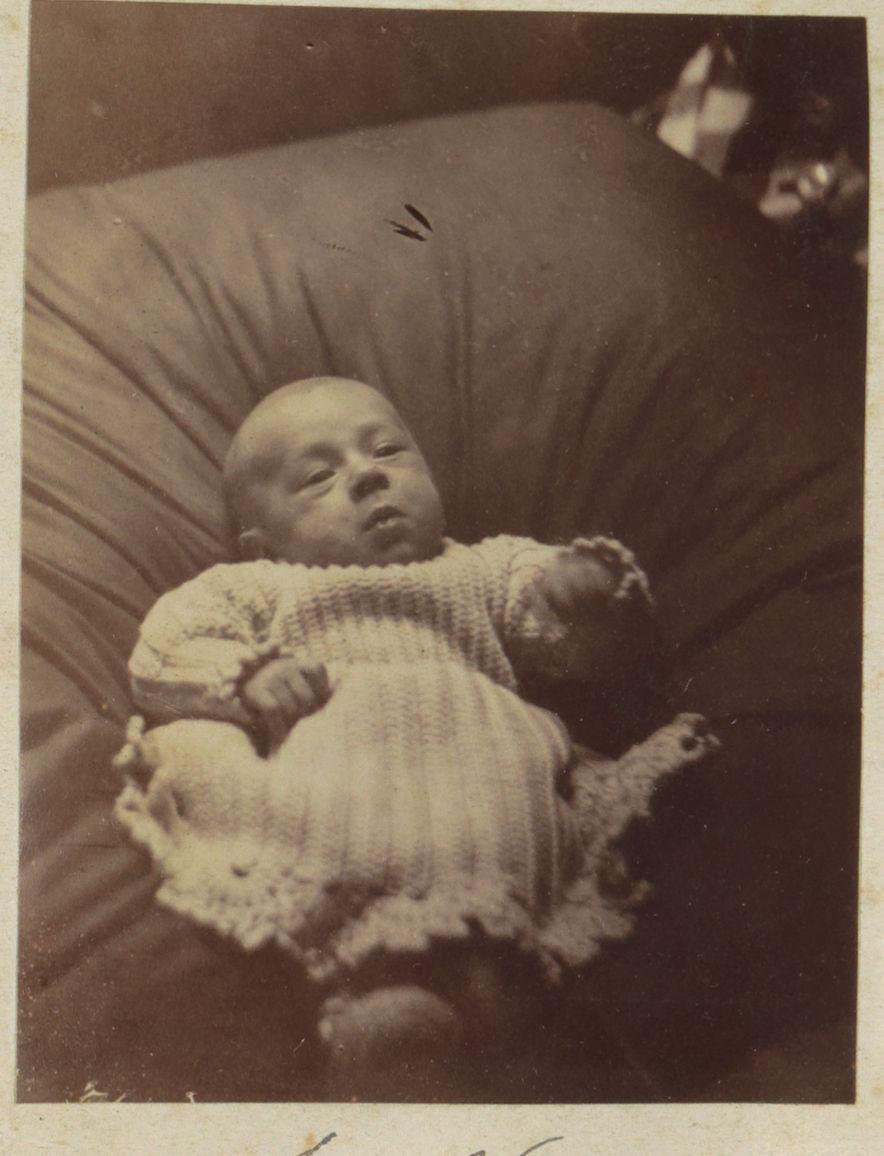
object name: photograph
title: Portret van een onbekende Franse baby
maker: Anonymous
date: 1886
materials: photographic support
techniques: albumen print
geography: france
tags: infant, baby ~ the ages of man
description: Onderdeel van Album van een Franse amateurfotograaf met opnames van familie, militairen, industrie, landschappen en bezienswaardigheden in Frankrijk.